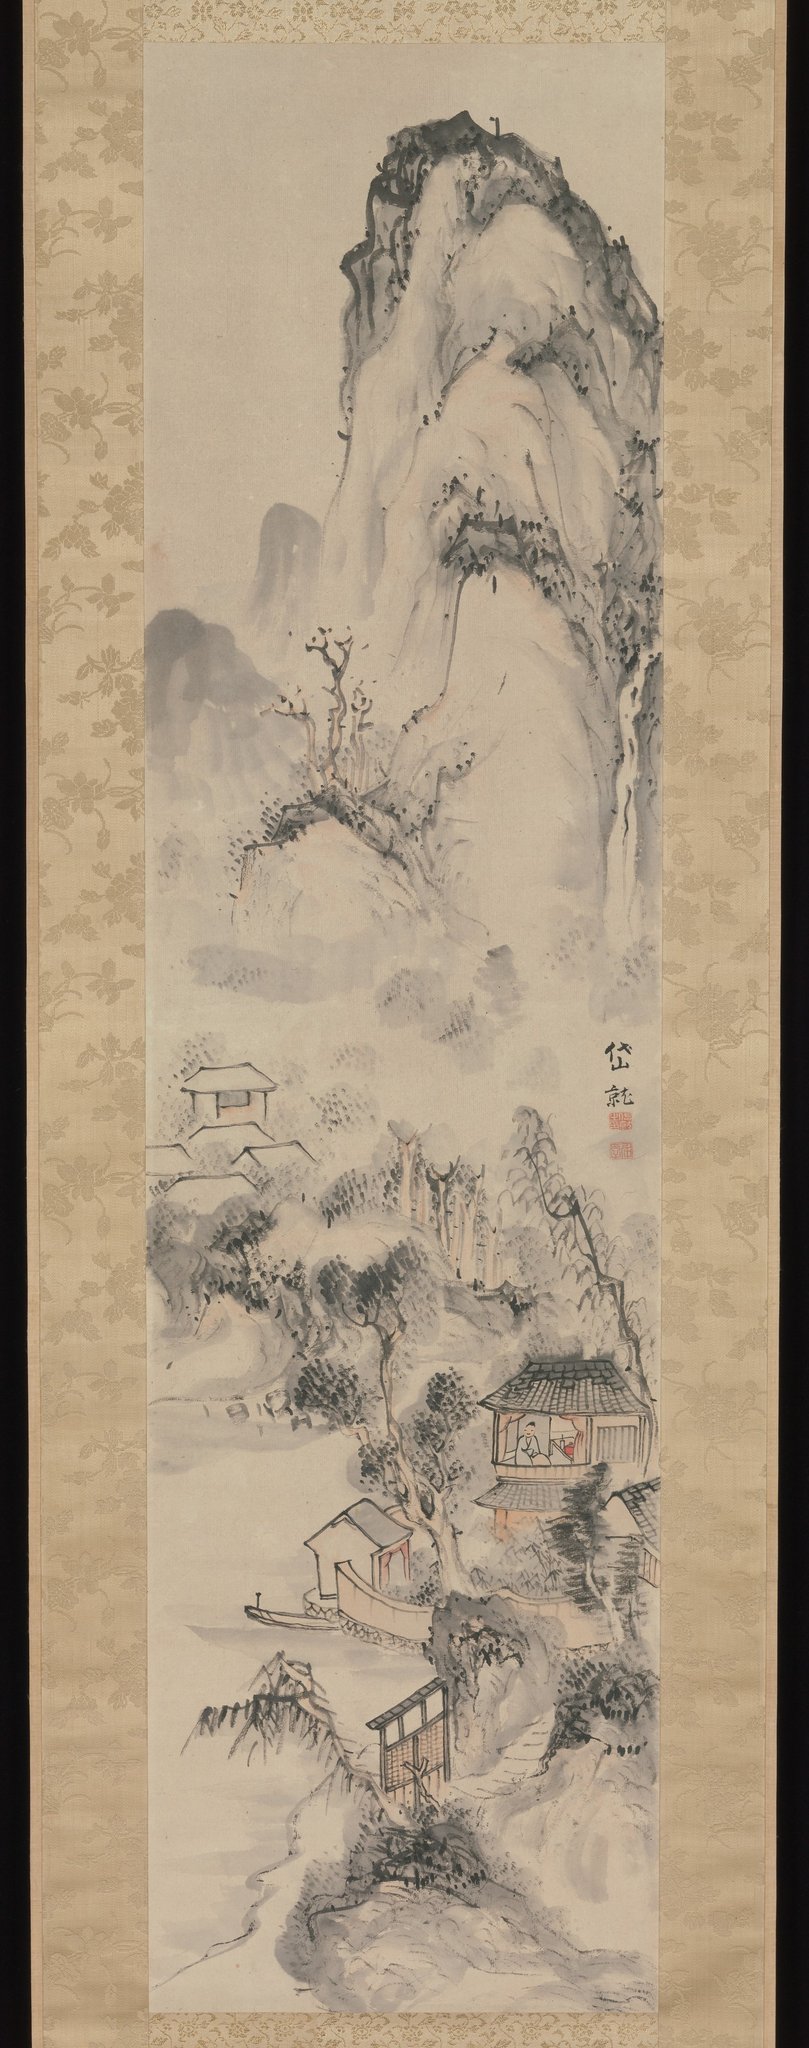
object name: hanging scroll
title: Landscape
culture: japanese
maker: kushiro unsen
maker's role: artist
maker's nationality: japanese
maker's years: 1759-1811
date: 1701-1800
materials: ink, paper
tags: mountains,landscapes,pavilions